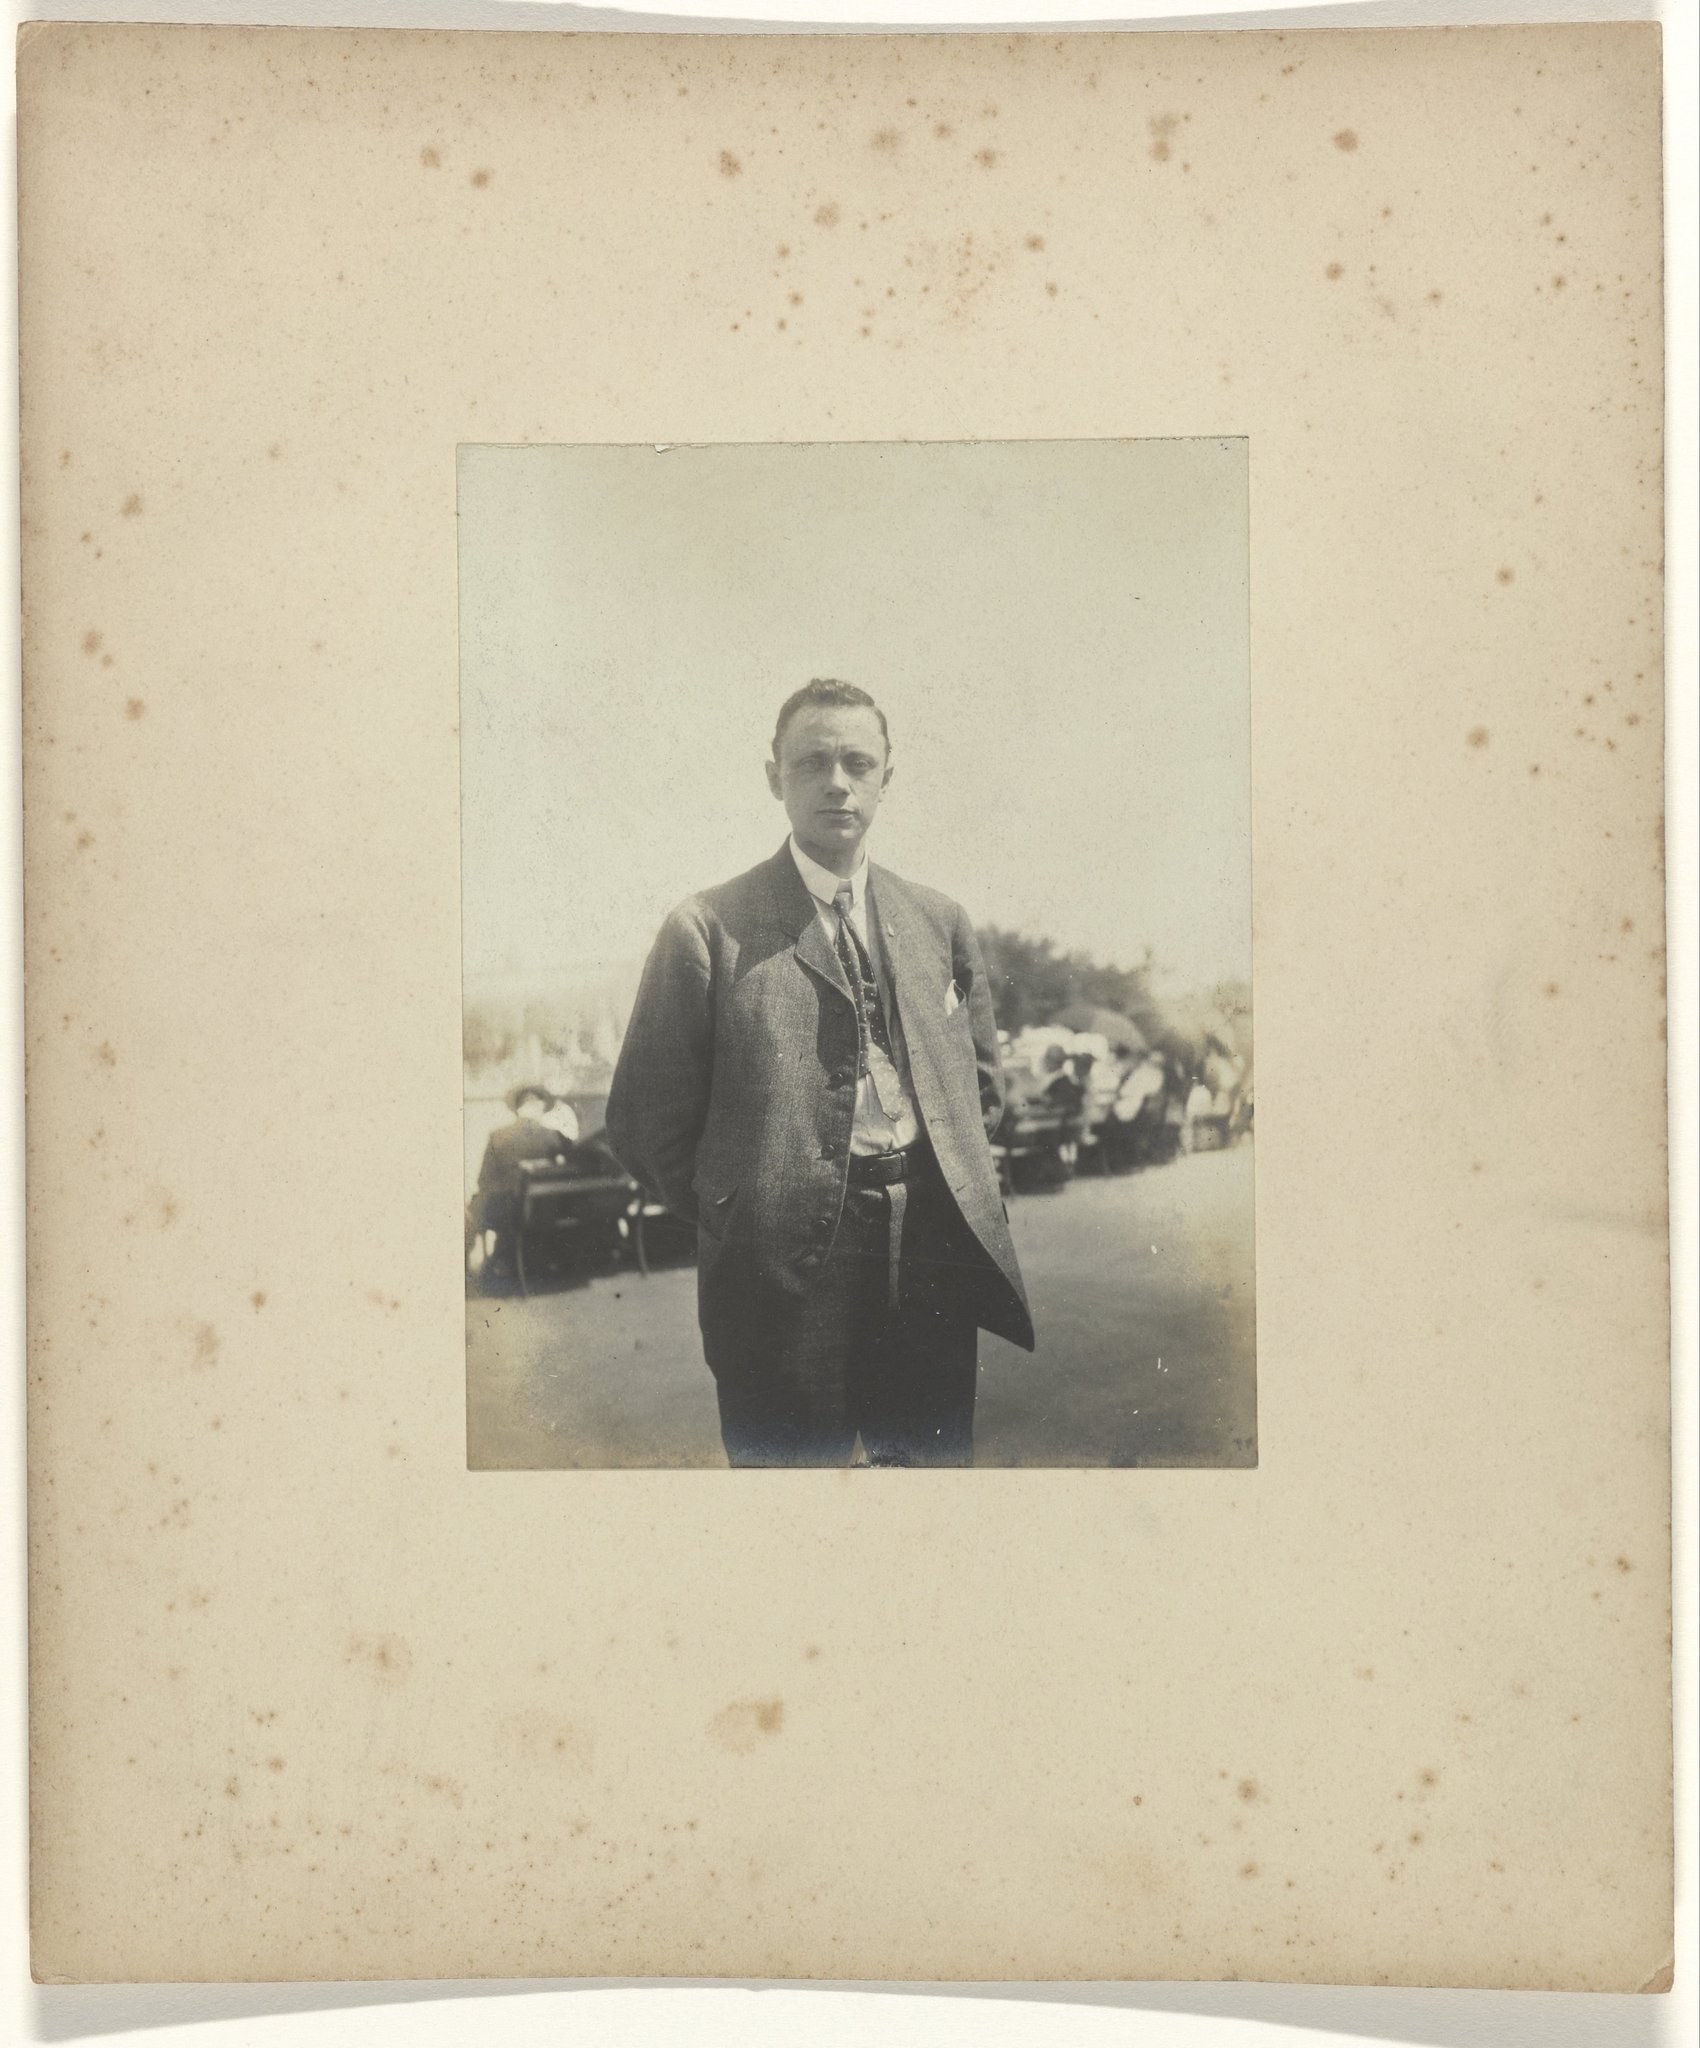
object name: photograph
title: Portret van Jan Catharinus Schüller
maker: Anonymous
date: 1904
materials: cardboard, paper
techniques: gelatin silver print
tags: print maker, draughtsman, jan schüller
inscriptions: annotation: ‘Een Pastoor’, annotation: ‘J.C. Schüller // Internat. Tentoonstelling // 1904-1905 // St-Louis . Louisiana // (nog zonder snor!)’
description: Portret van Jan Catharinus Schüller, kunsthandelaar en vertegenwoordiger van de Nederlandse kunsthandelaren op de wereldtentoonstelling in St. Louis (Louisiana Purchase Exposition), 1904.